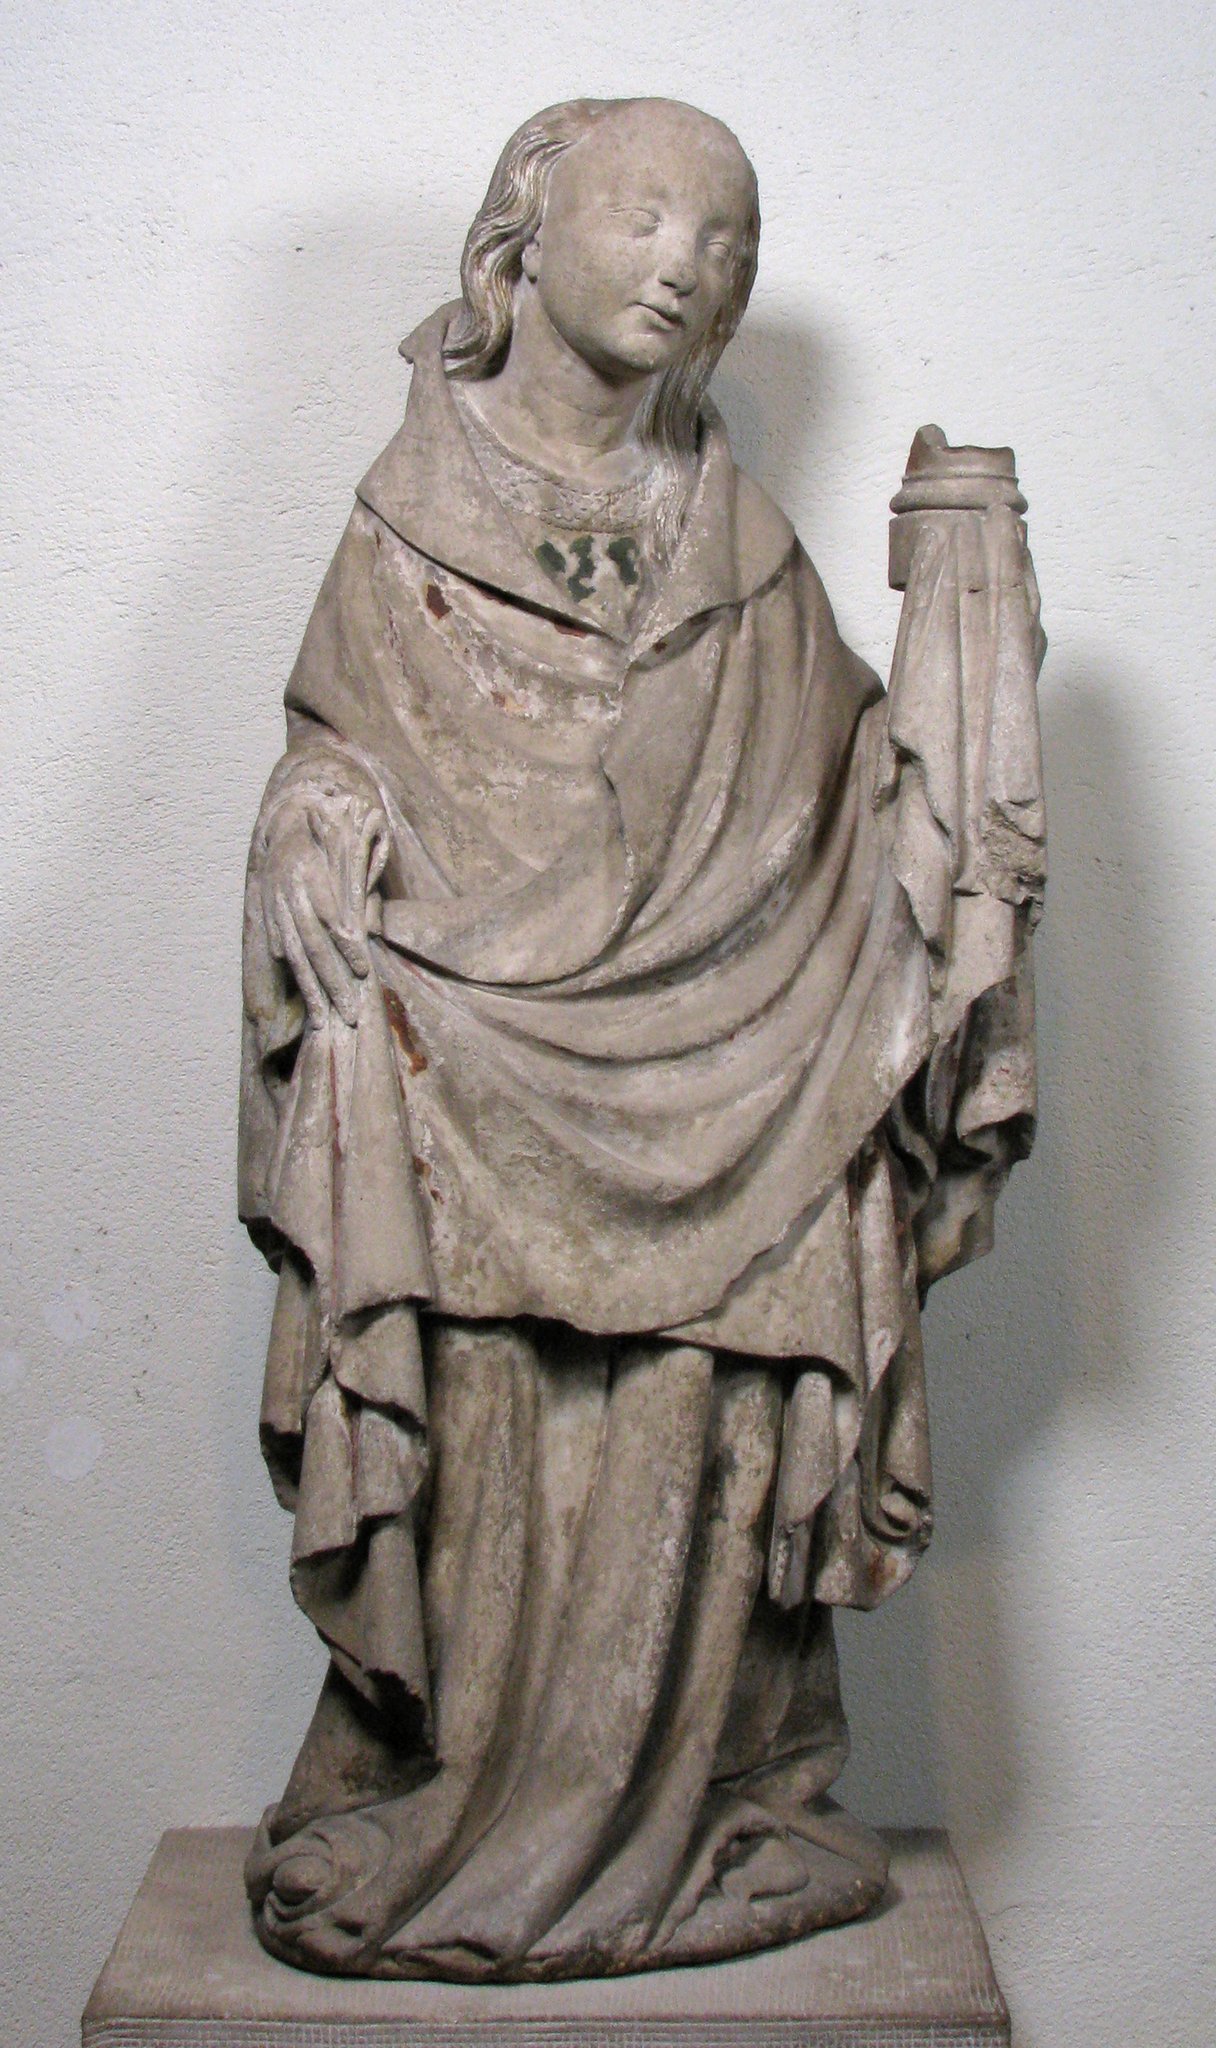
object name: statue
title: Saint Barbara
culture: french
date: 1434-1466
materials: limestone, paint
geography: france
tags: women,saints